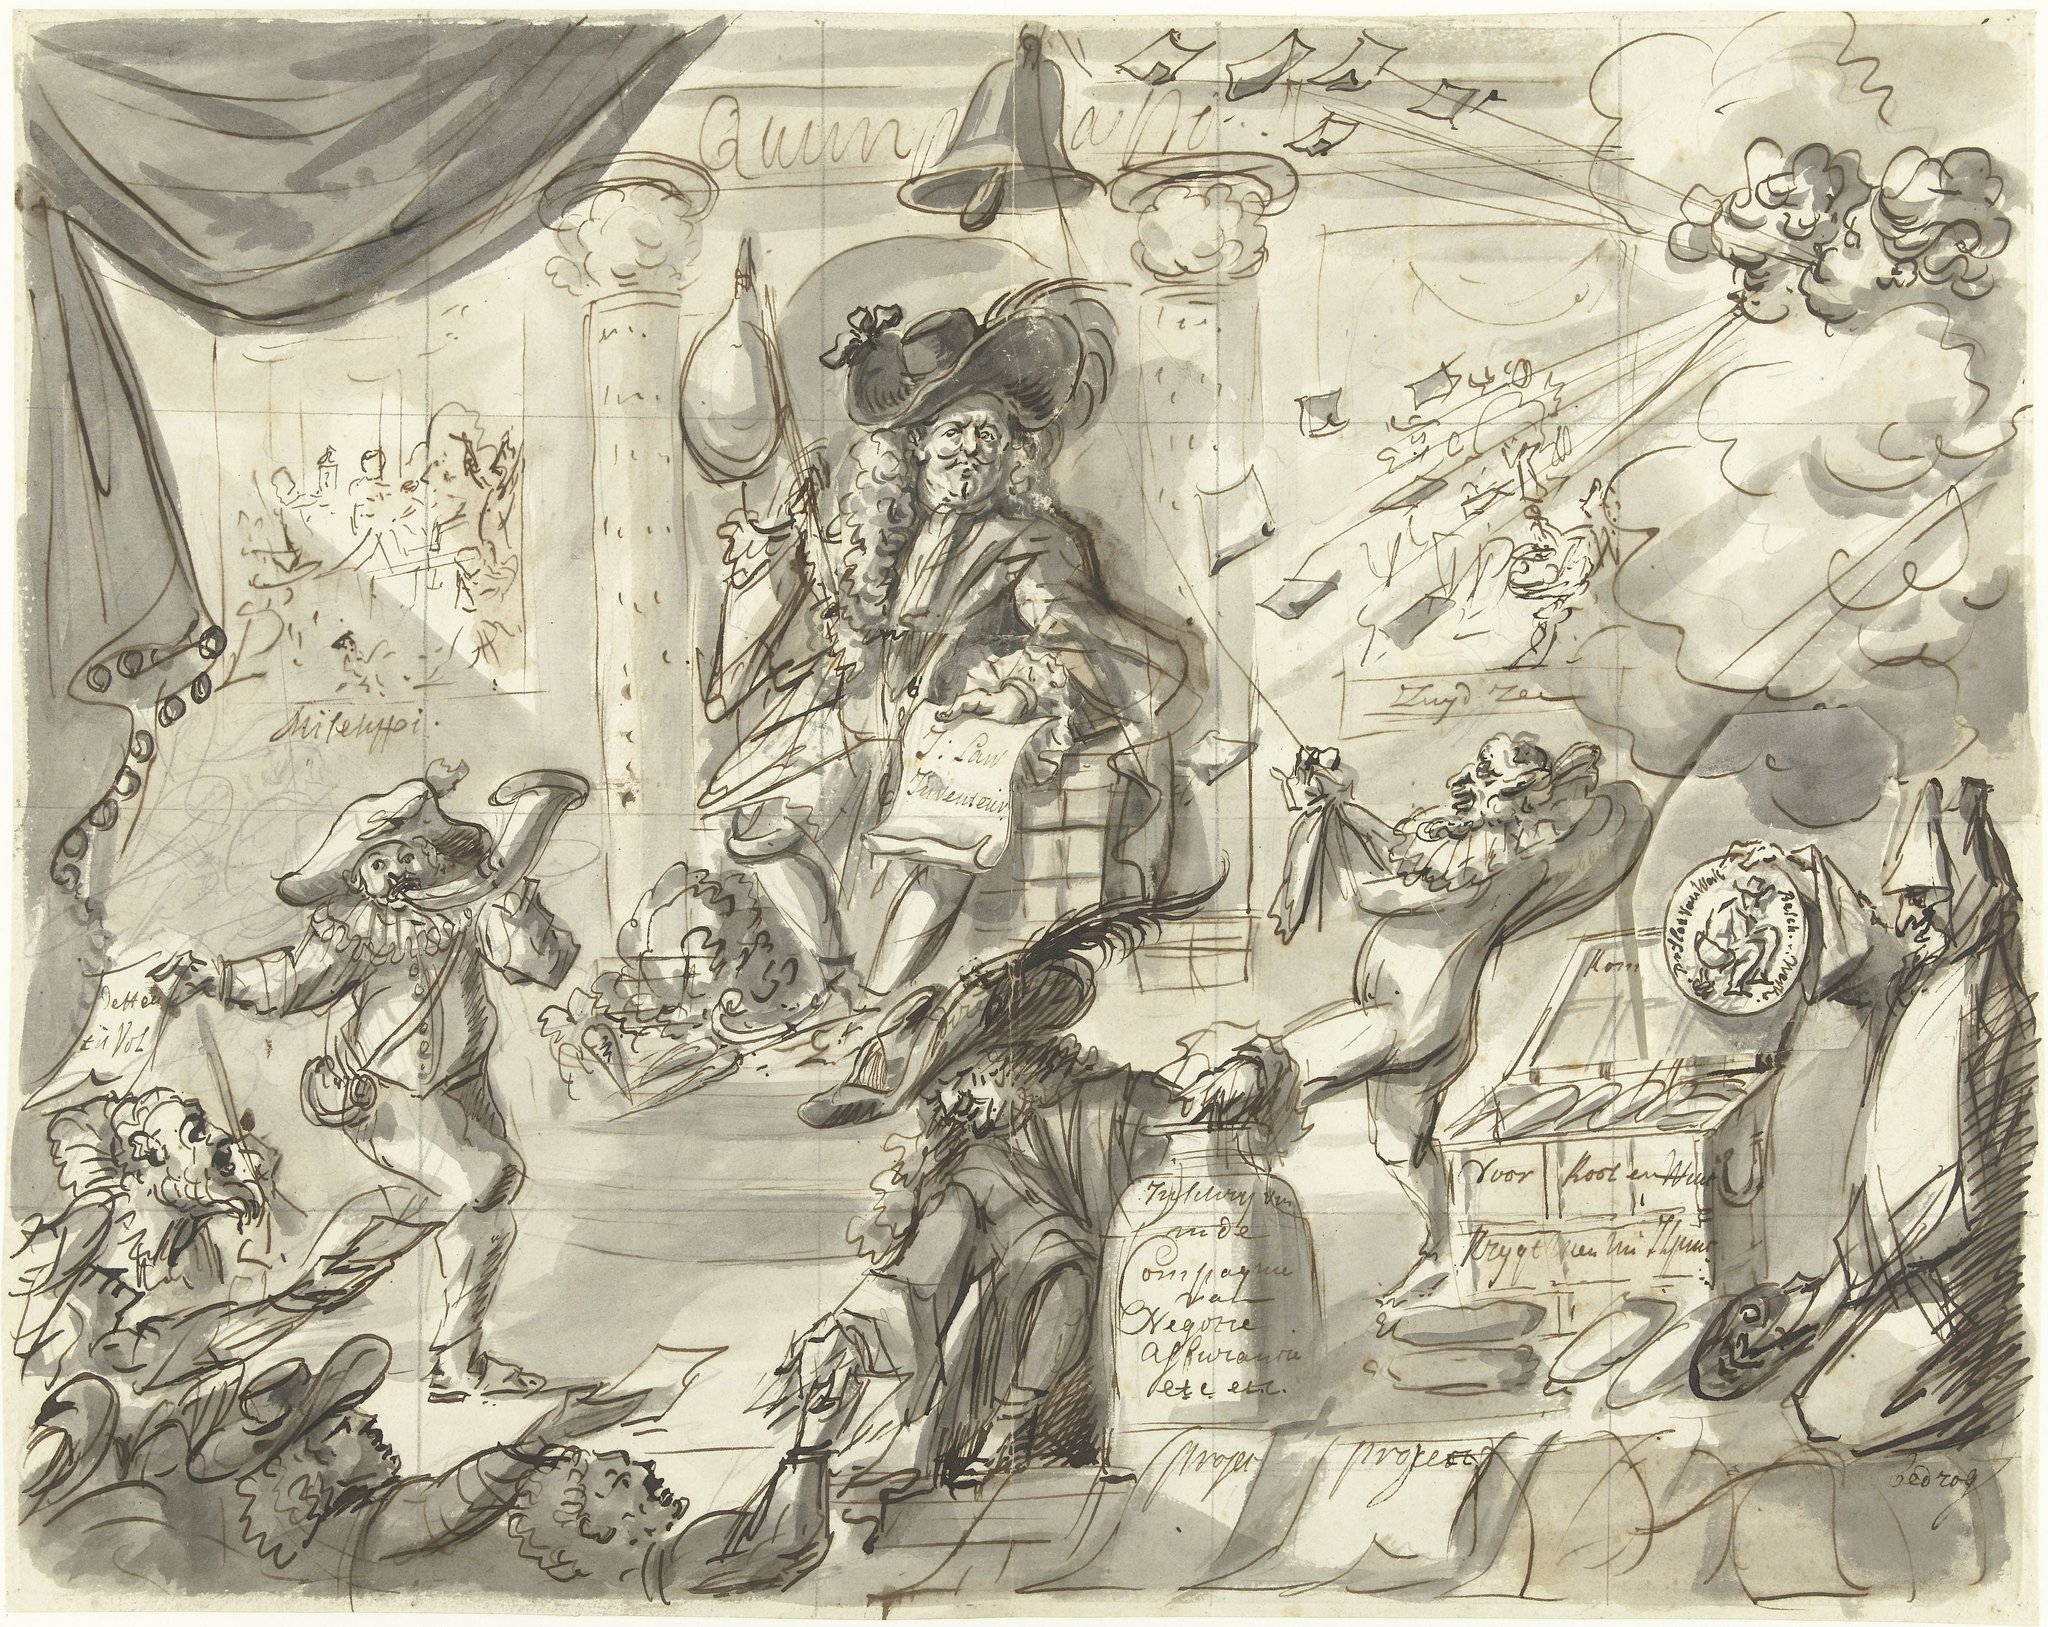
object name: drawing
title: Quincampoix of de grote Wind en Koolverkoper, 1720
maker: Anonymous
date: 1720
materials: paper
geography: northern netherlands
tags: speculative boom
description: Quincampoix of de grote Wind en Koolverkoper. Johan Law zittend op zijn troon, rechts luidt Bombario de noodklok, links een bode met een hoorn. Op de voorgrond het uitdelen van aandelen aan het publiek, rechts deelt Bedrog maskers uit en blaast een windkop aandelen over het toneel. Ontwerptekening voor een niet uitgevoerde prent in een serie over de opkomst en ondergang van Quincampoix (John Law). Bij de tekening behoort een uitleg. Behoort tot de groep van tekeningen toegevoegd aan de serie Tafereel der Dwaasheid met spotprenten op de Windhandel of Actiehandel van 1720.